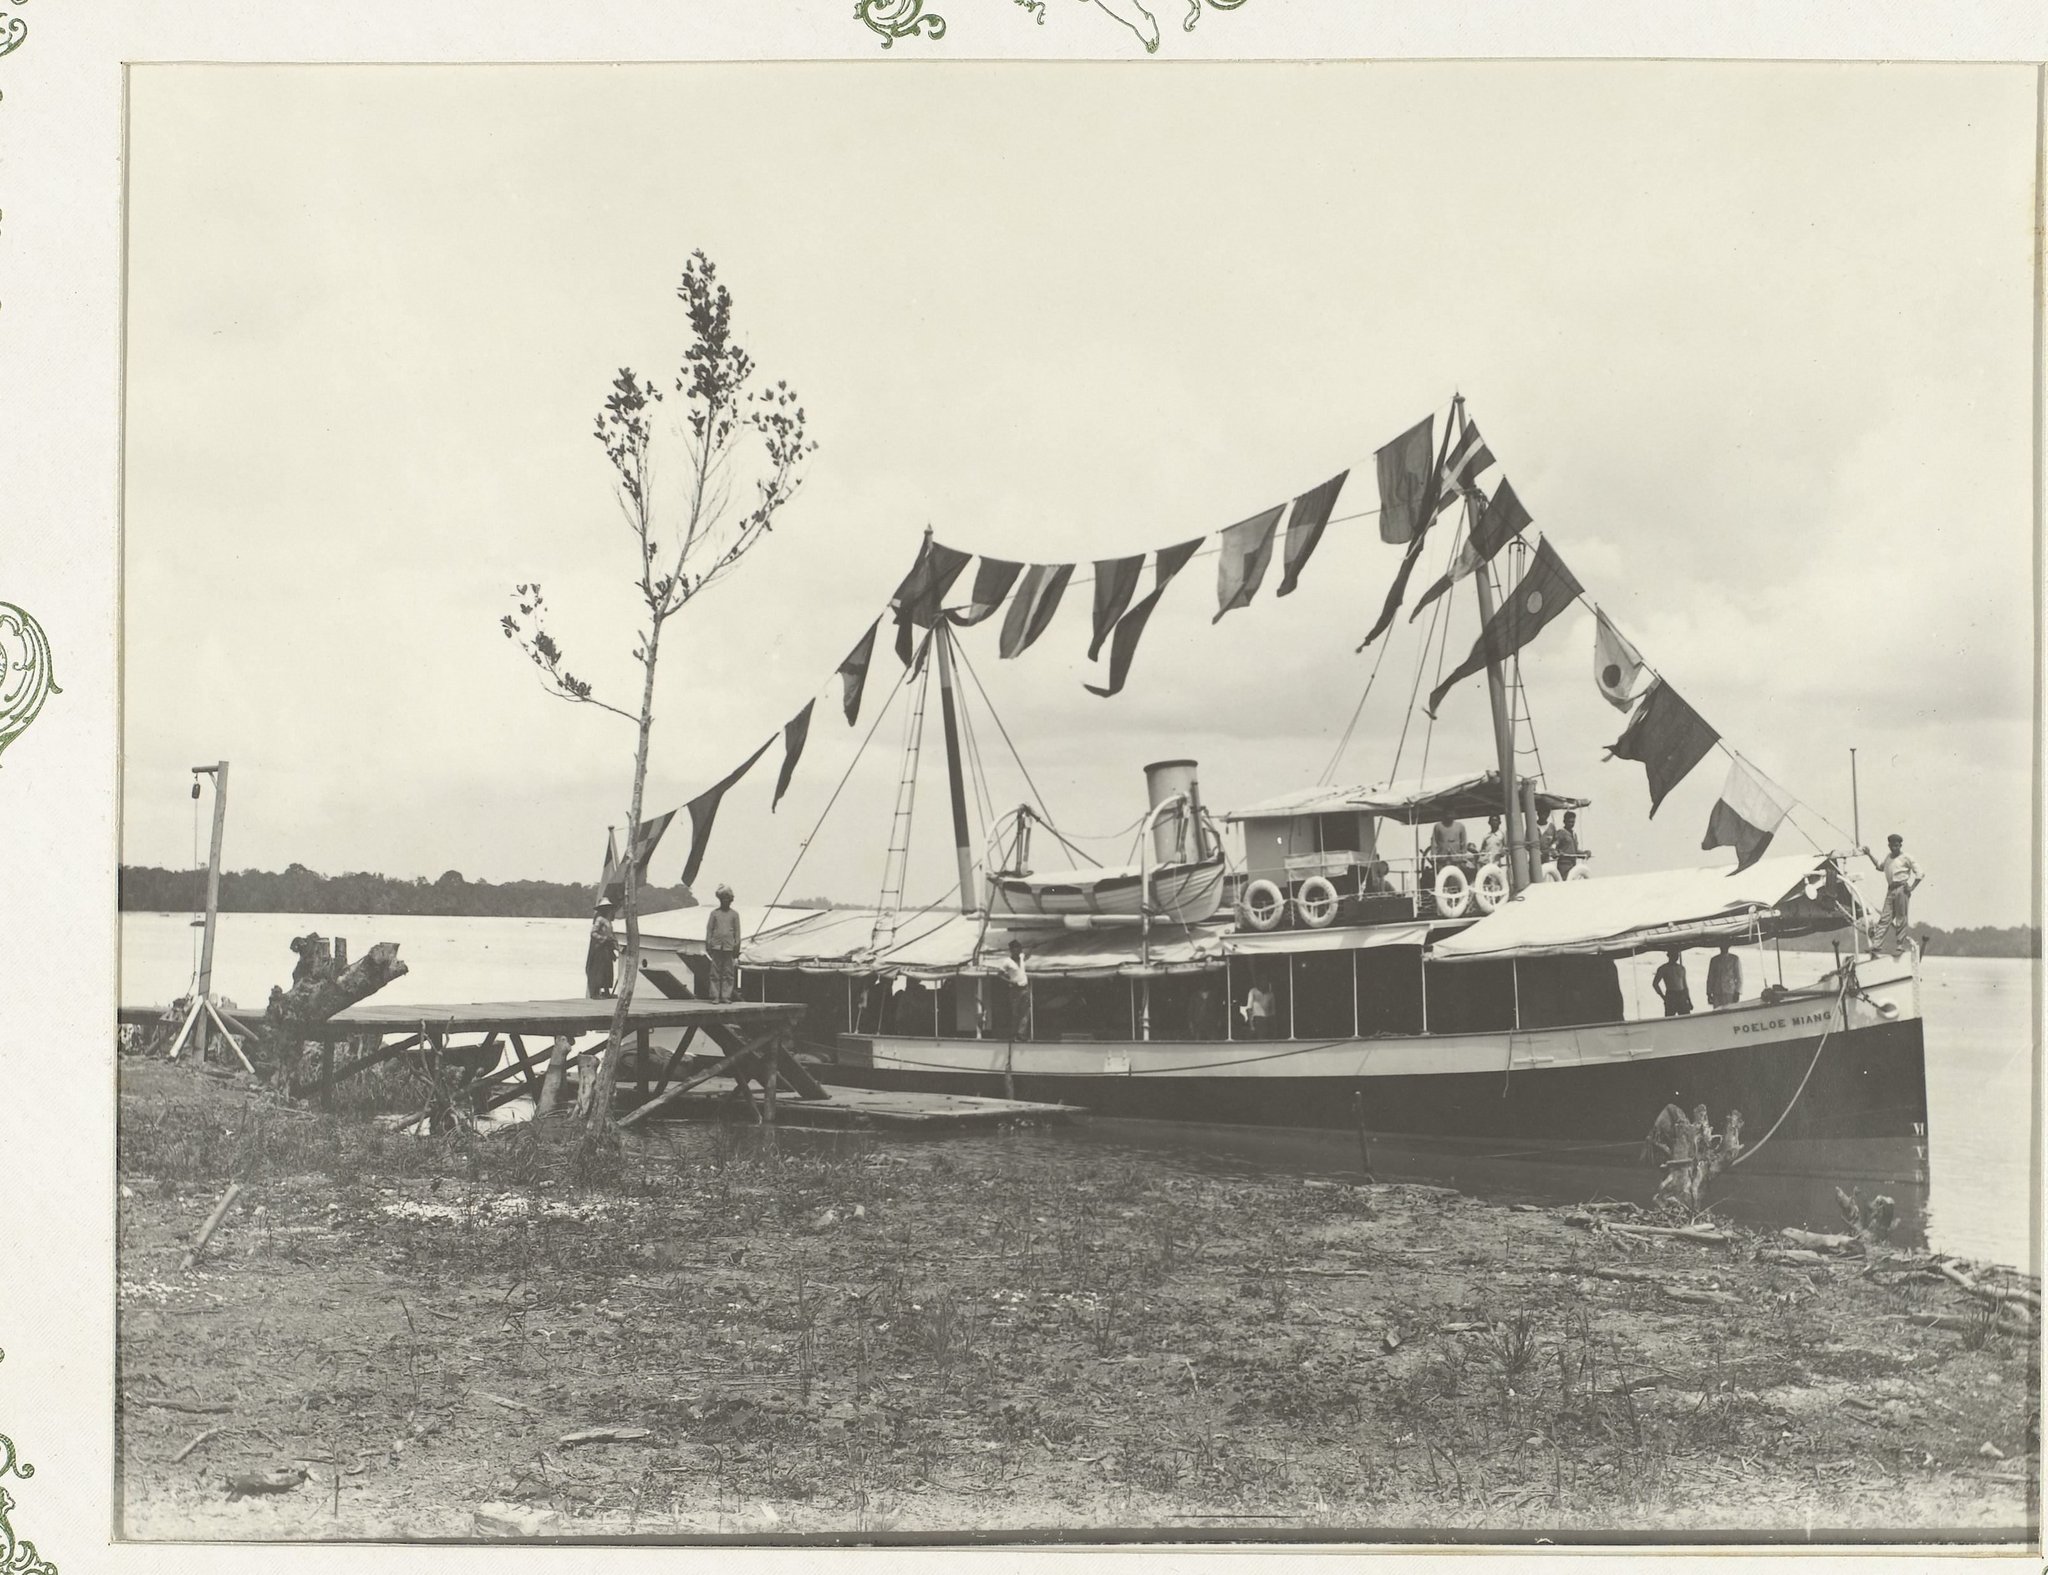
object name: photograph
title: Schip aan steiger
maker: Anonymous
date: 1903-1907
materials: paper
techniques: gelatin silver print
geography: kalimantan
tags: steamship, motorship, borneo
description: Een schip (de Poeloe Miang) gelegen aan een steiger te Borneo. Foto in het fotoalbum over de oliewinning op Borneo door de Koninklijke Nederlandsche Petroleum Maatschappij (KNPM) in de jaren 1903-1907.